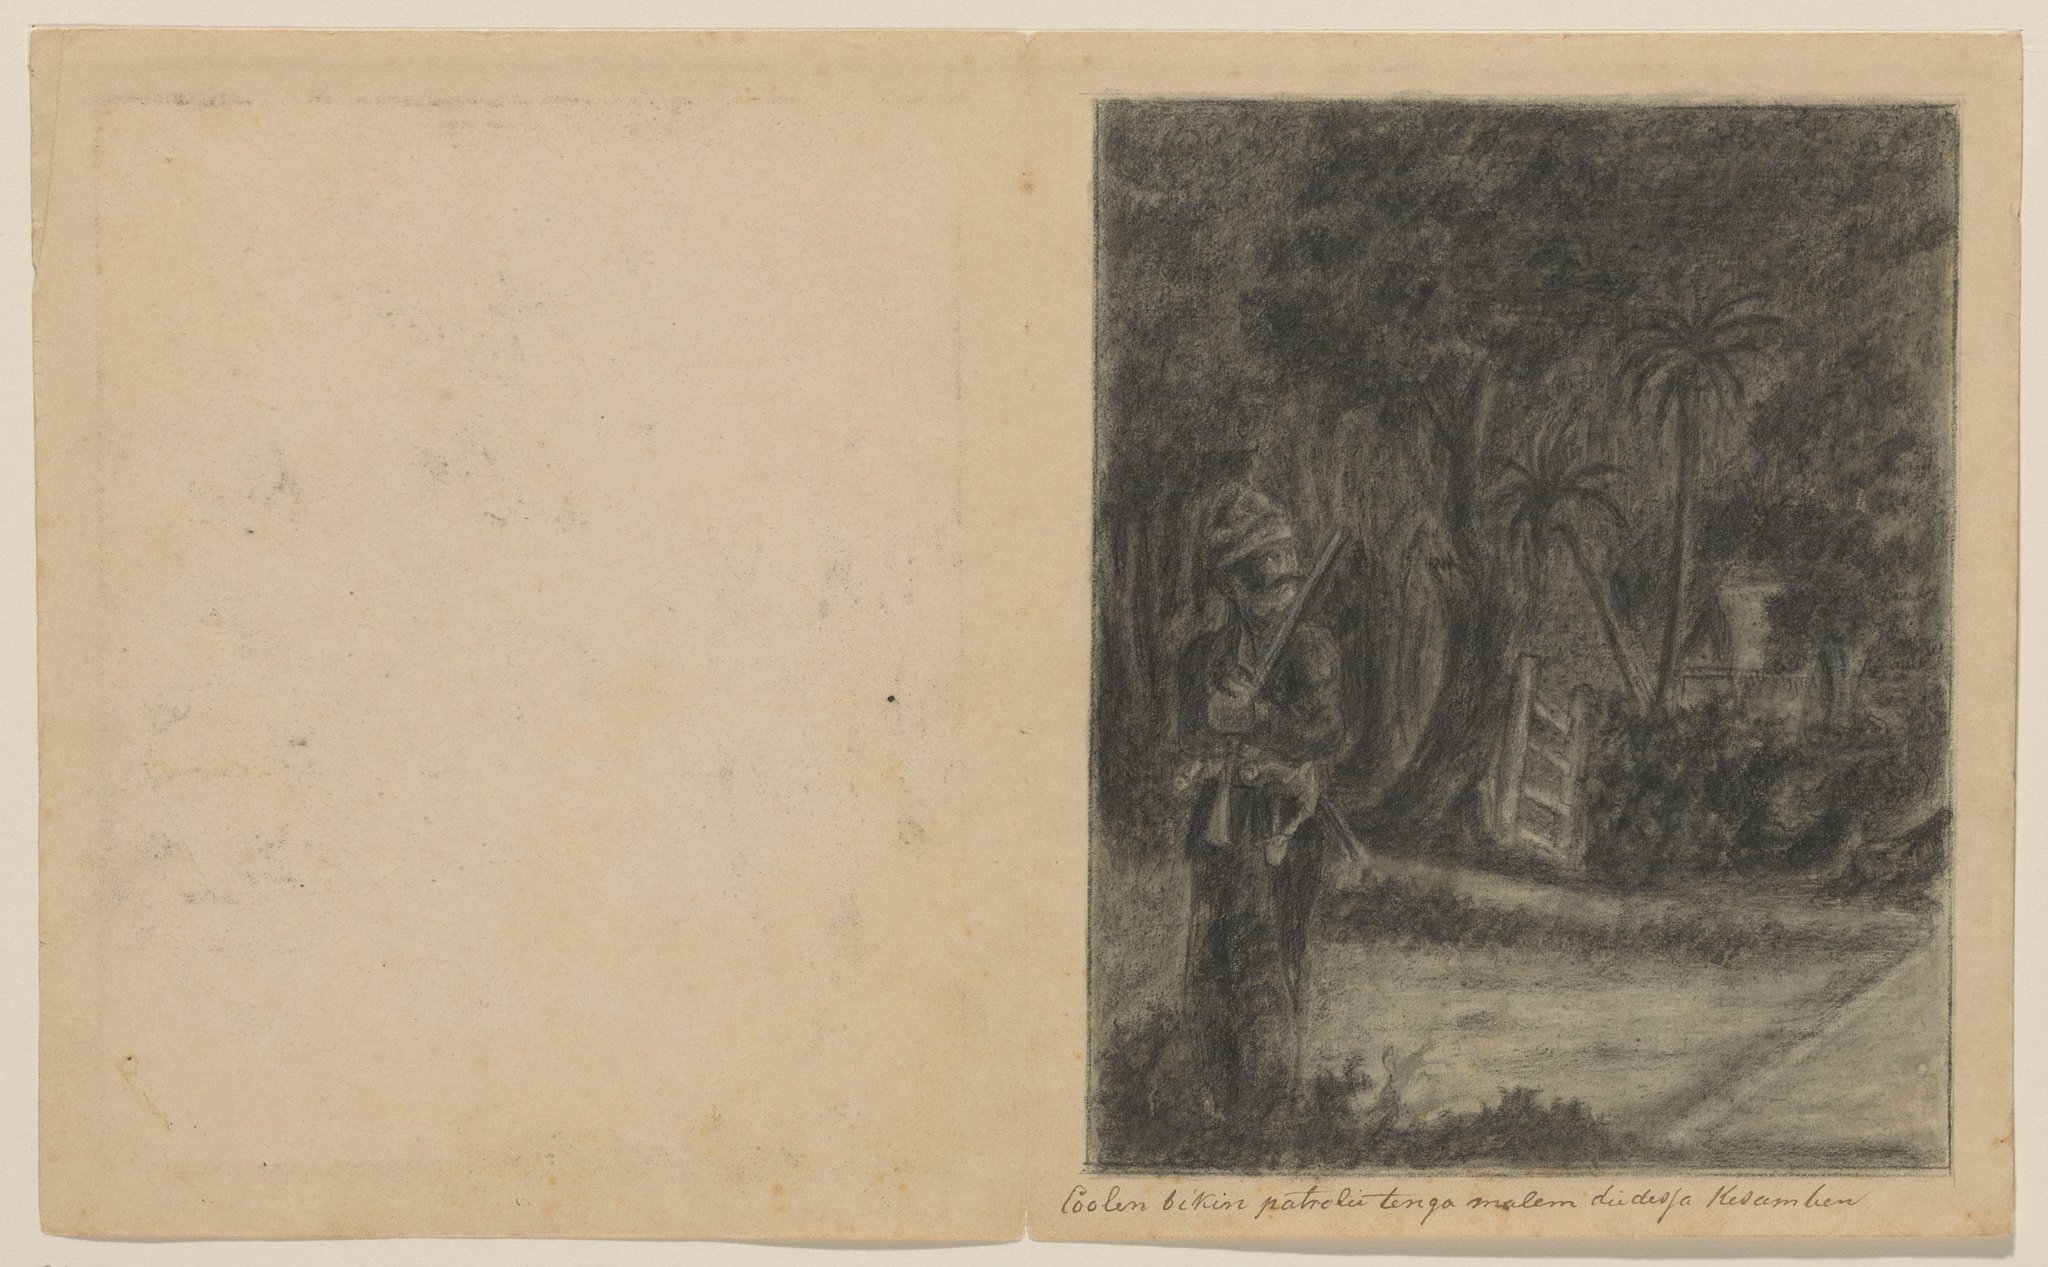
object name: drawing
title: Coolen op patrouille in het dorp Kesamben, ca. 1820-1850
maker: Anonymous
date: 1850-1950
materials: chalk, paper, pencil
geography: indonesia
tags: coenraad laurens coolen, oost-java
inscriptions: collector's mark: Lugt 2228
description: Coolen op patrouille 's nachts in het dorp Kesamben. Onderdeel van een groep van twaalf losse bladen uit een schetsboek met tekeningen over het leven van Coenraad Laurens Coolen, evangelist op Oost-Java, ca. 1820-1850. Elk blad heeft een tekening op de rechterhelft, met een onderschrift in het Indonesisch.